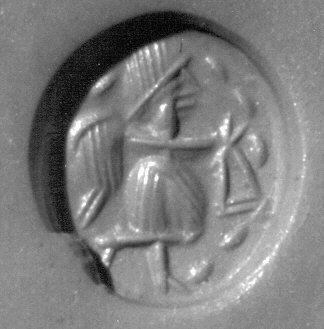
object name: stamp seal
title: Stamp seal and modern impression: winged figure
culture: sasanian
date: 201-700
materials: gemstone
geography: iran